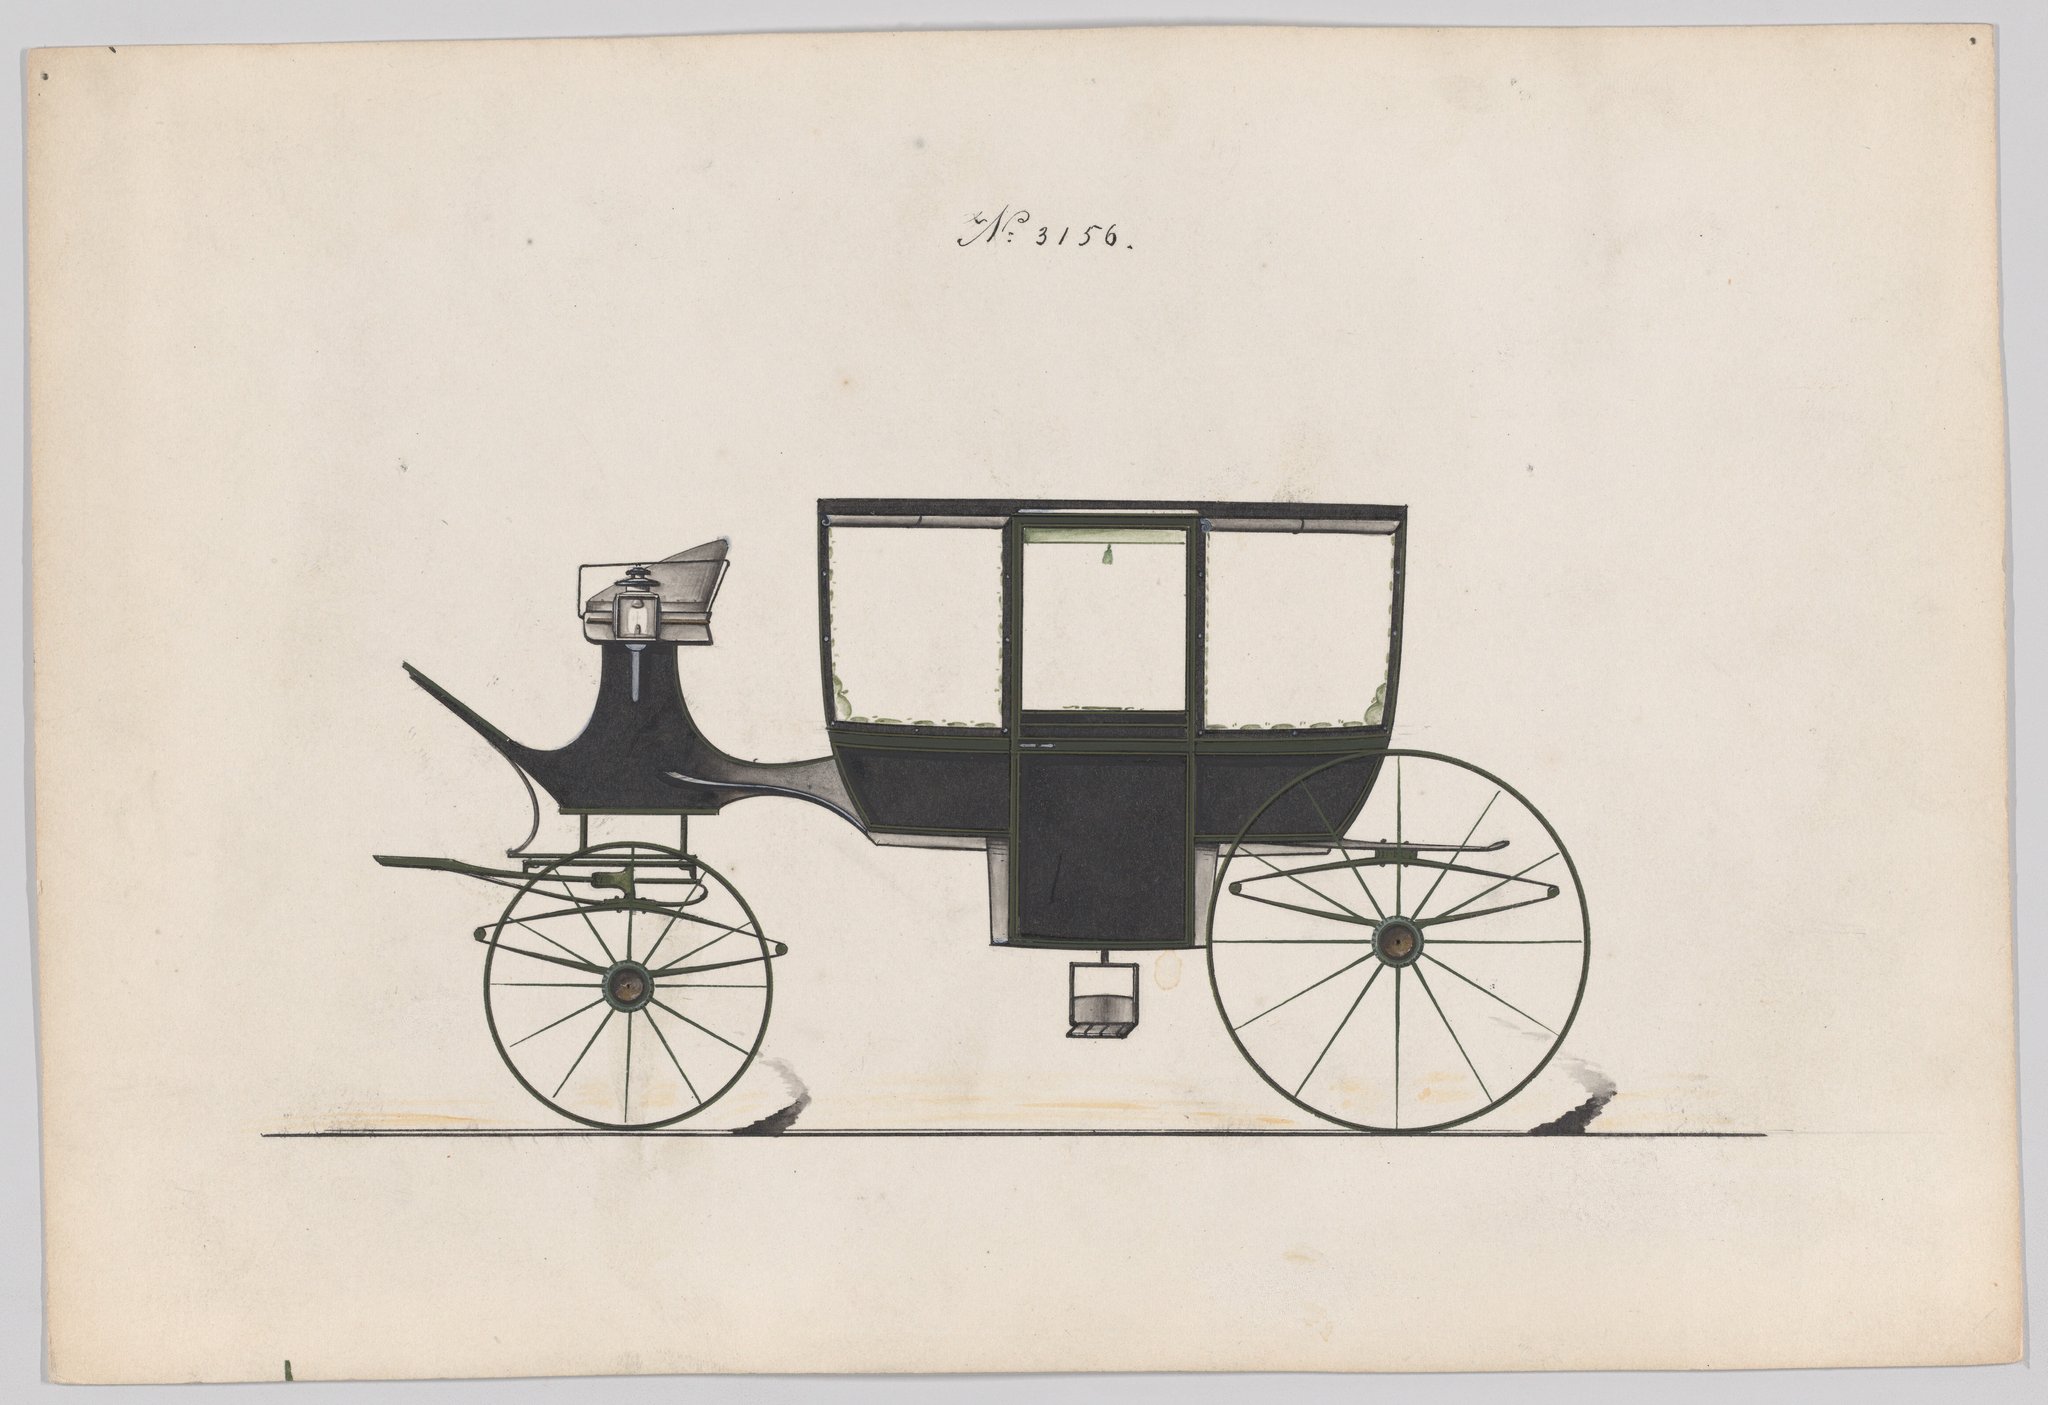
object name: drawing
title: Coach #3156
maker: brewster & co.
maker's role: manufacturer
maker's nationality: american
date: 1875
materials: gouache, ink, watercolor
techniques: pen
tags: carriages